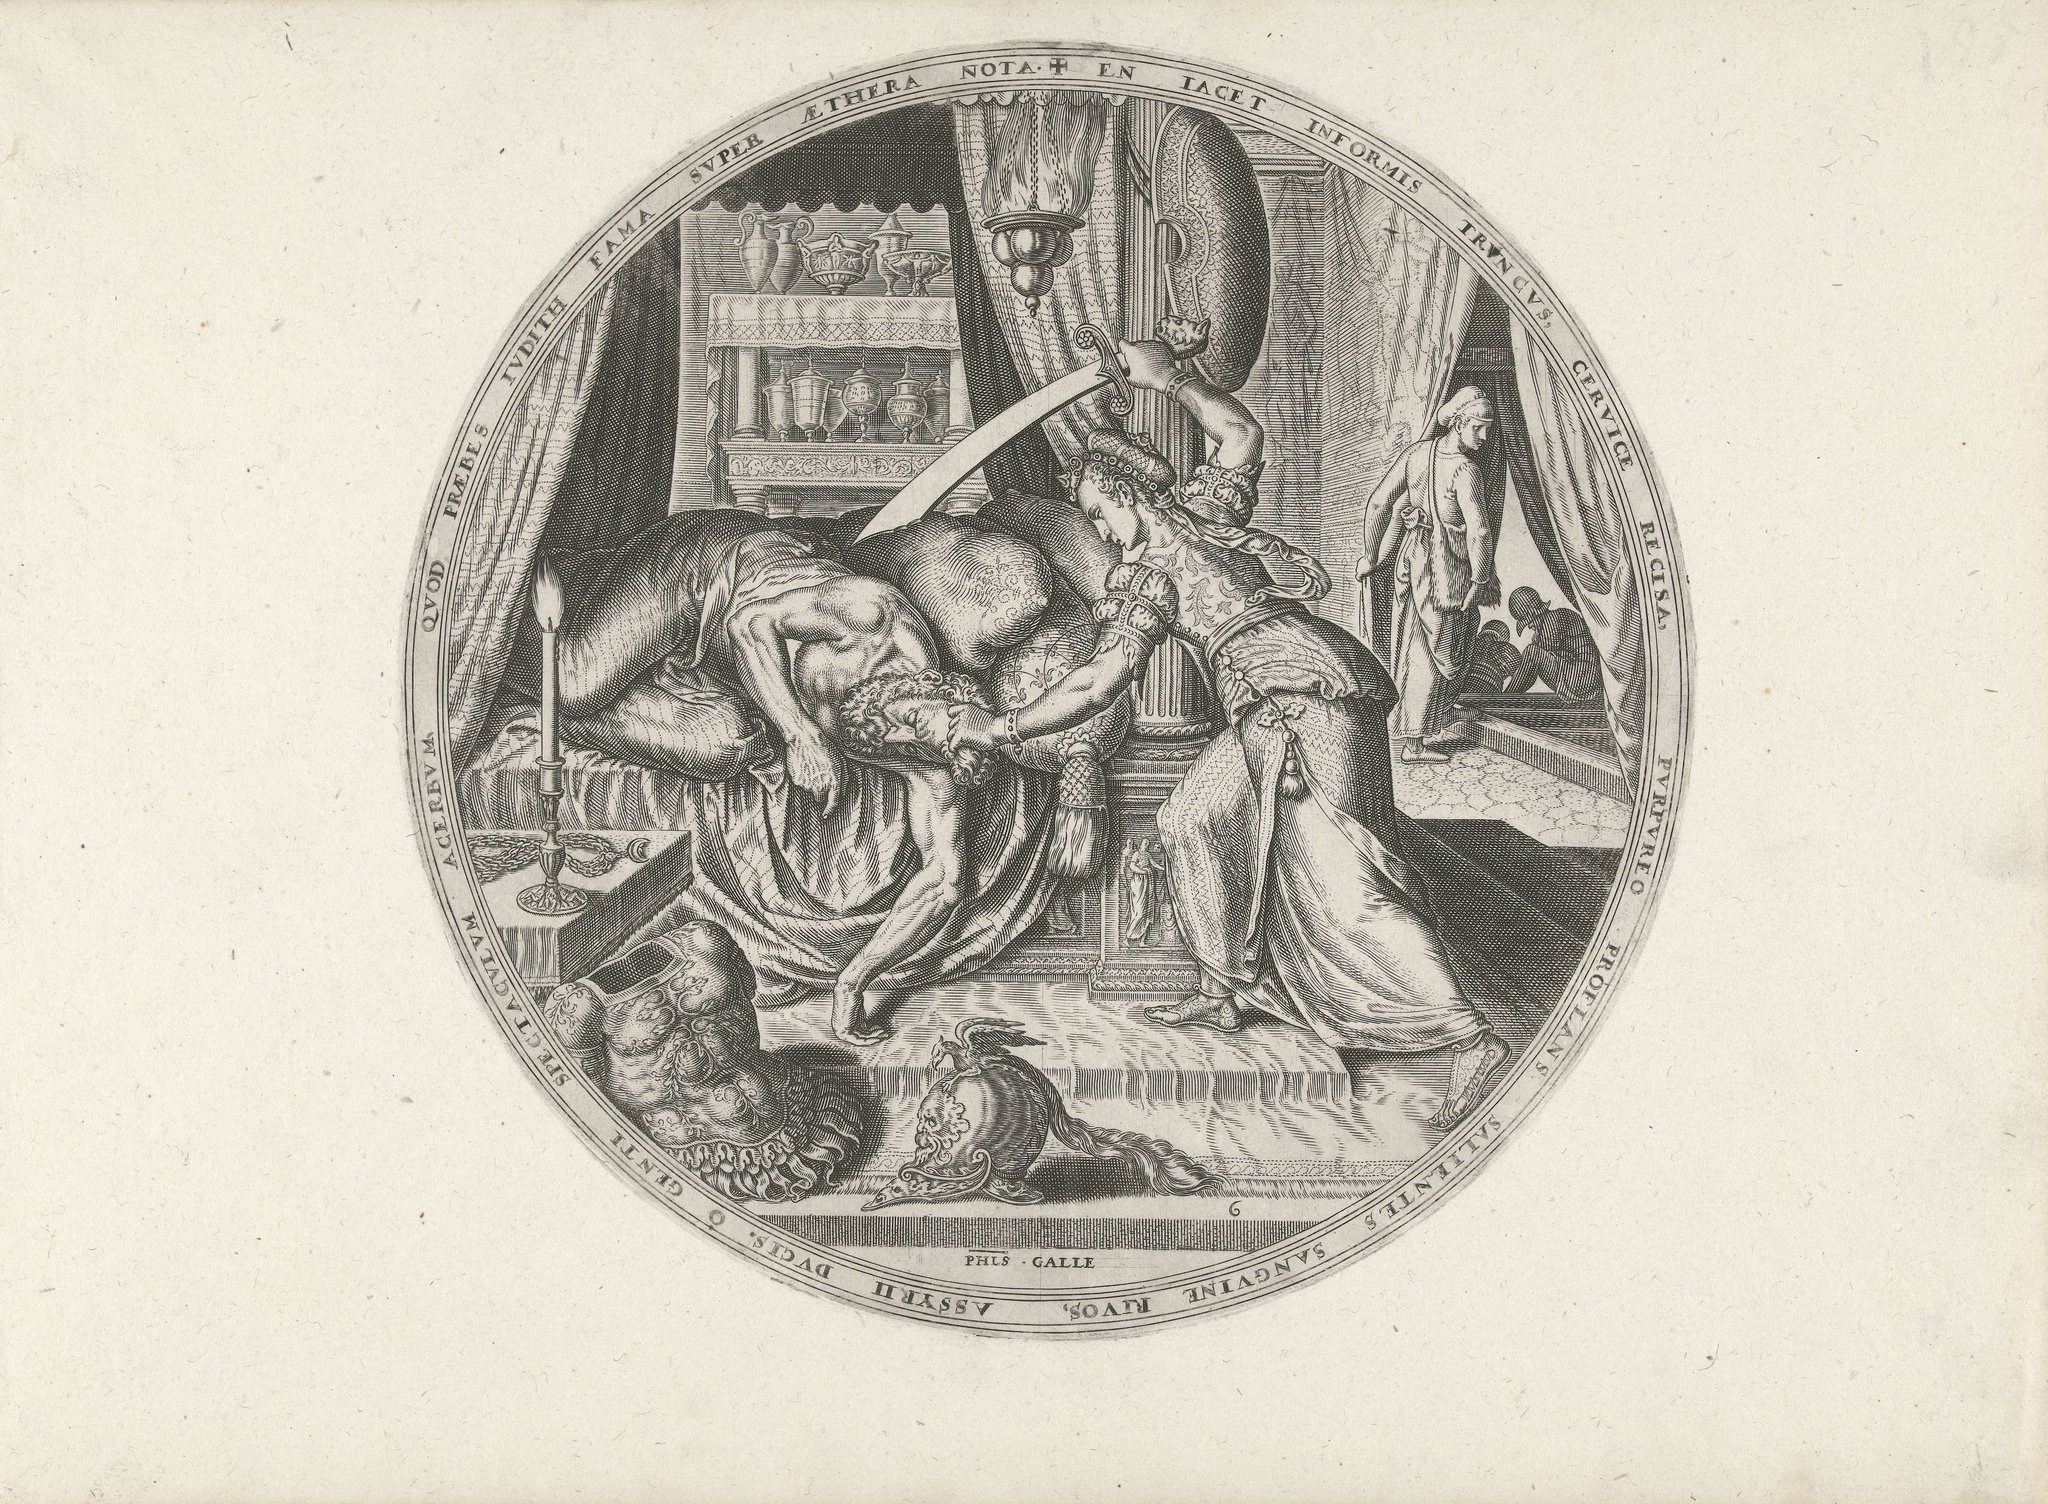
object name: print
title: Zes beroemde vrouwen uit het Oude Testament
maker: philips galle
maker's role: print maker, publisher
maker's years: 1537-1612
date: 1569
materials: paper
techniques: engraving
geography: haarlem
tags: holofernes beheaded by judith with his own sword; the maidservant may be keeping watch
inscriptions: collector's mark: Lugt 2228, collector's mark: Lugt 2760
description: Judit onthoofdt Holofernes met zijn eigen zwaard. Haar dienares houdt de wacht bij de tentingang. Holofernes lag in zijn bed te slapen. Zijn wapenrusting ligt op de grond voor het bed.